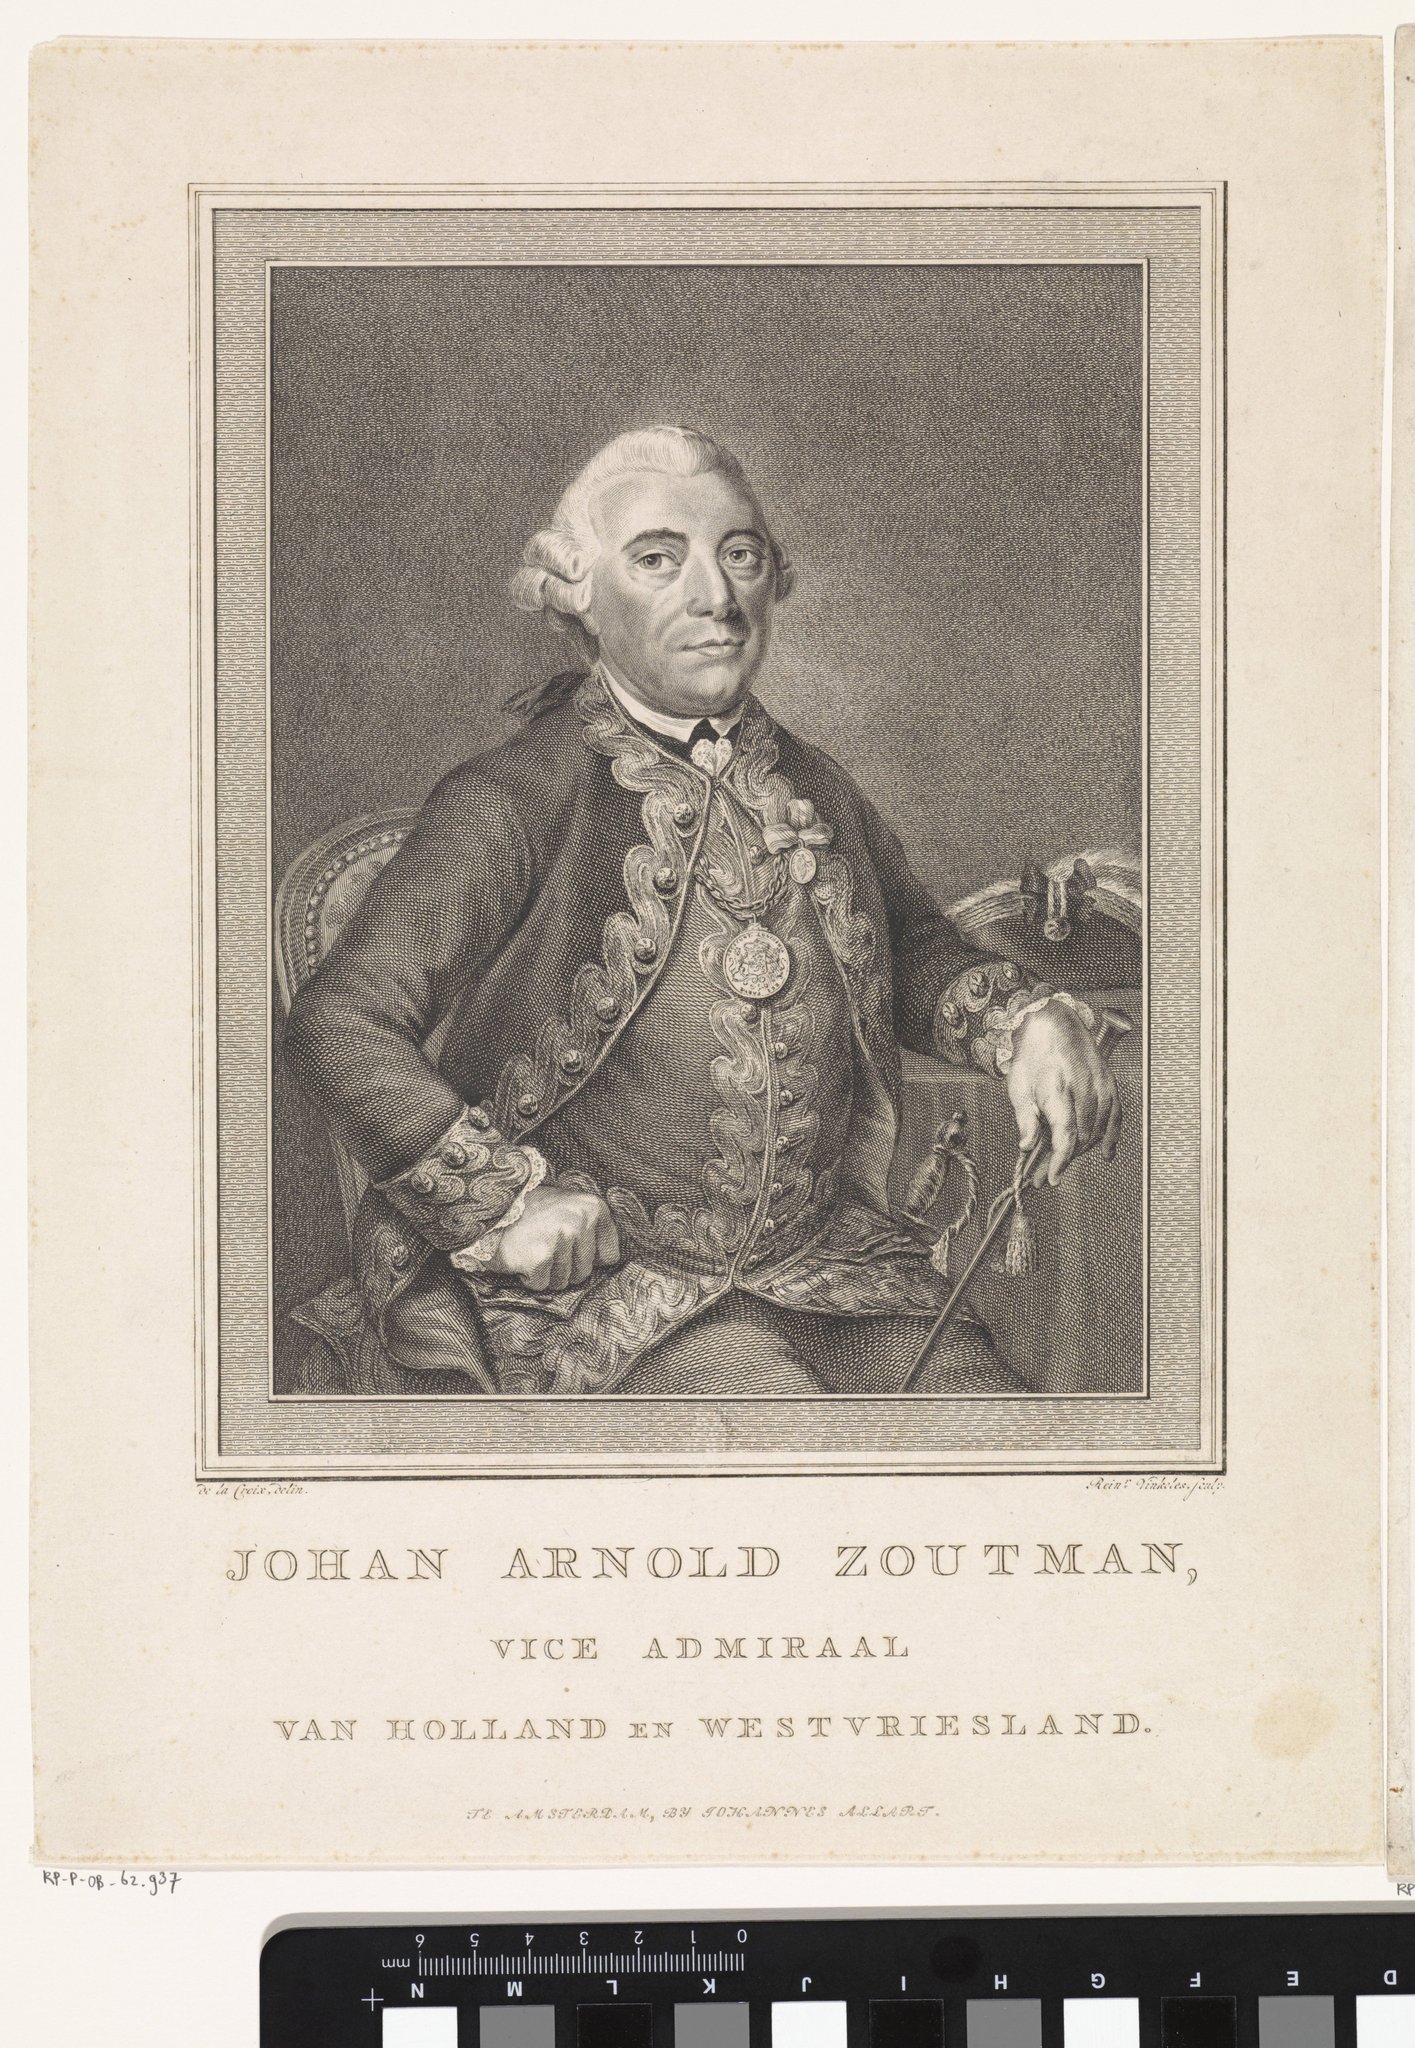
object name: print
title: Portret van Johan Arnold Zoutman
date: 1781-1816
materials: paper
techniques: engraving, etching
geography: amsterdam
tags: the hague, johan arnold zoutman, medal, badge of a guild (+ variant)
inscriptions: collector's mark: Lugt 2228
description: Portret van Johan Arnold Zoutman, zittend op een stoel, zijn elleboog leunt op een tafel. Om zijn hals zijn ontvangen gedenkpenning voor de zeeslag bij Doggersbank.